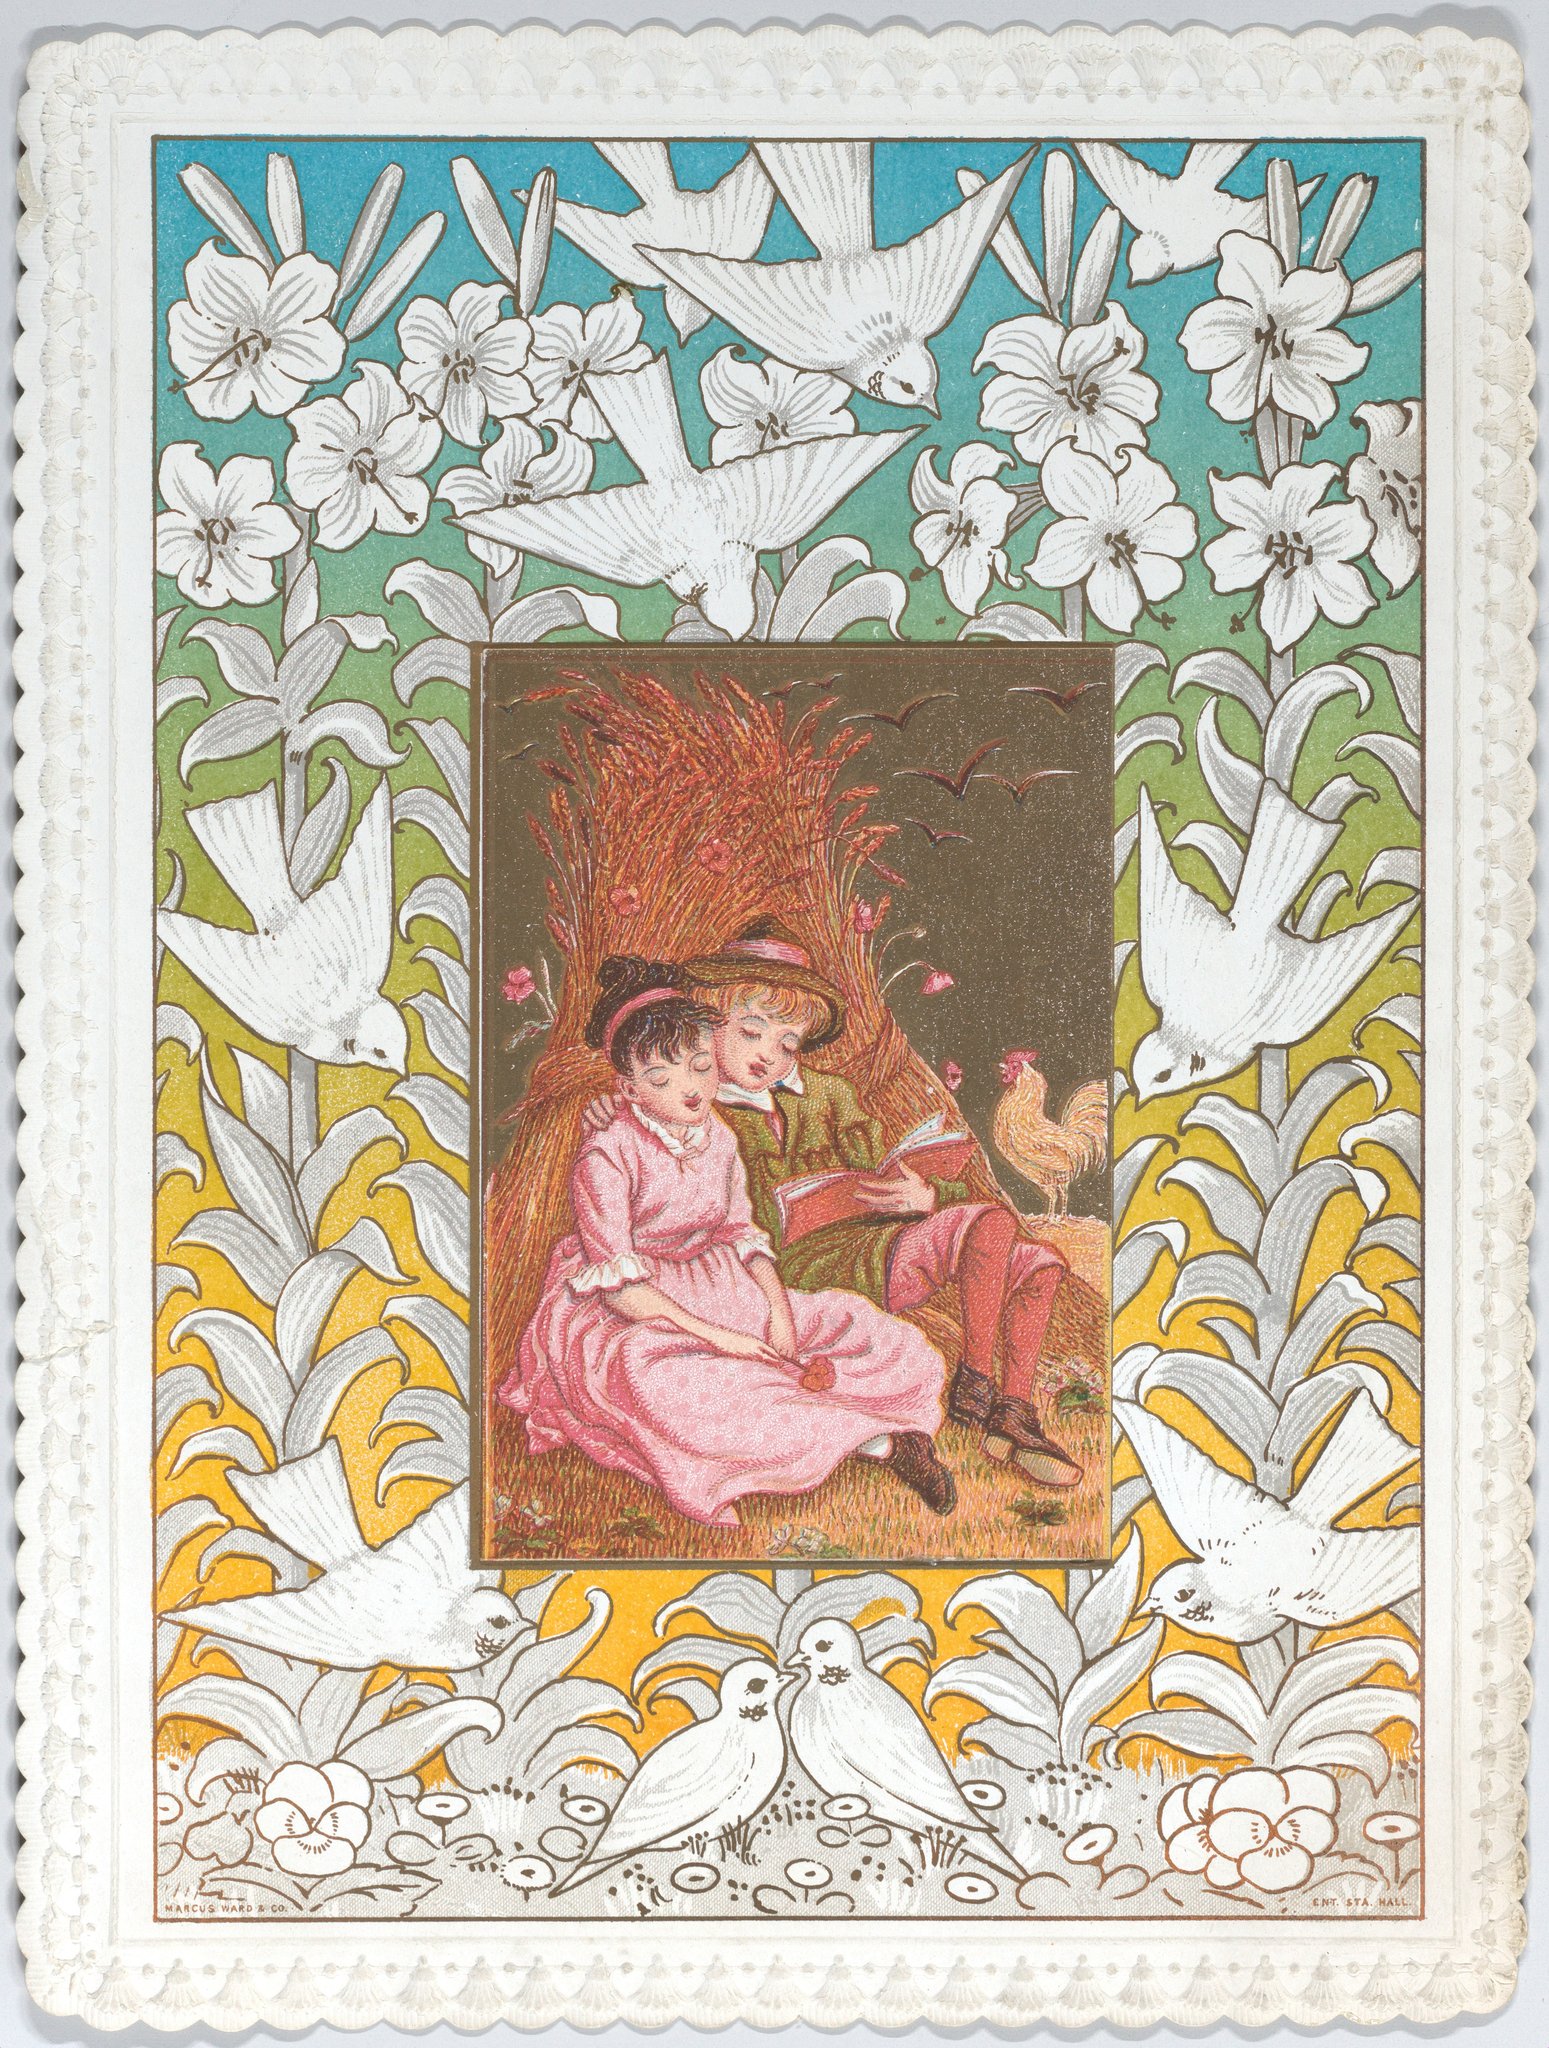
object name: valentine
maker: kate greenaway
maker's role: artist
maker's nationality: british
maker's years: 1846-1901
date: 1876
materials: gold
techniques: chromolithography, embossing, gilding, lithograph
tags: doves,boys,girls,reading